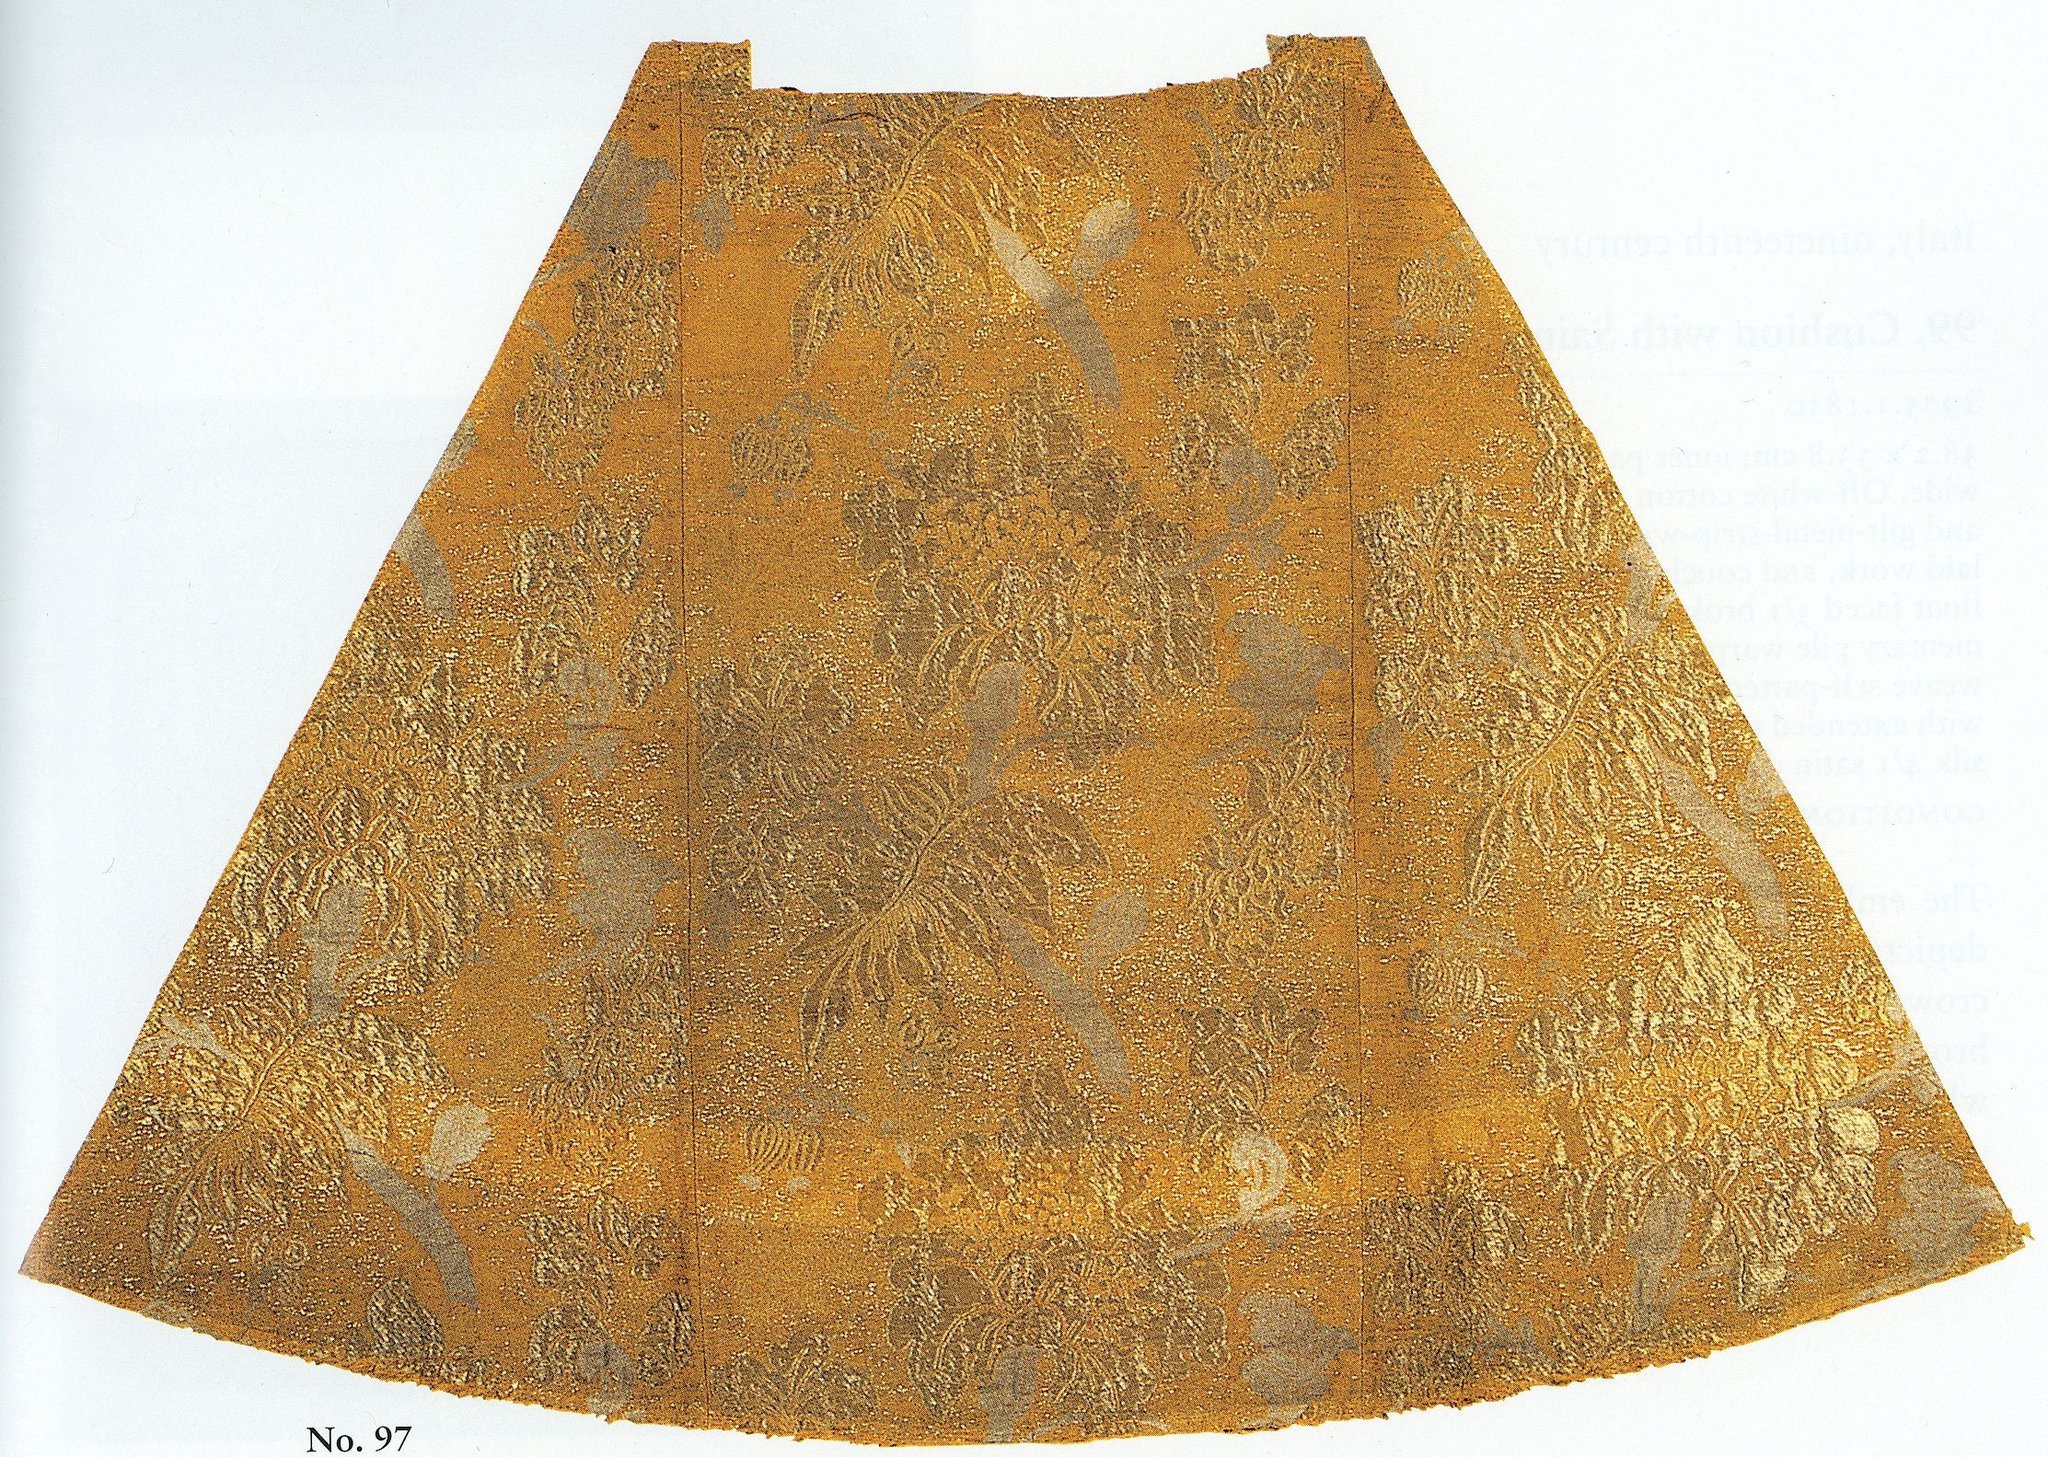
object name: dress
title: Madonna dress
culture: russian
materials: cotton, metal, silk